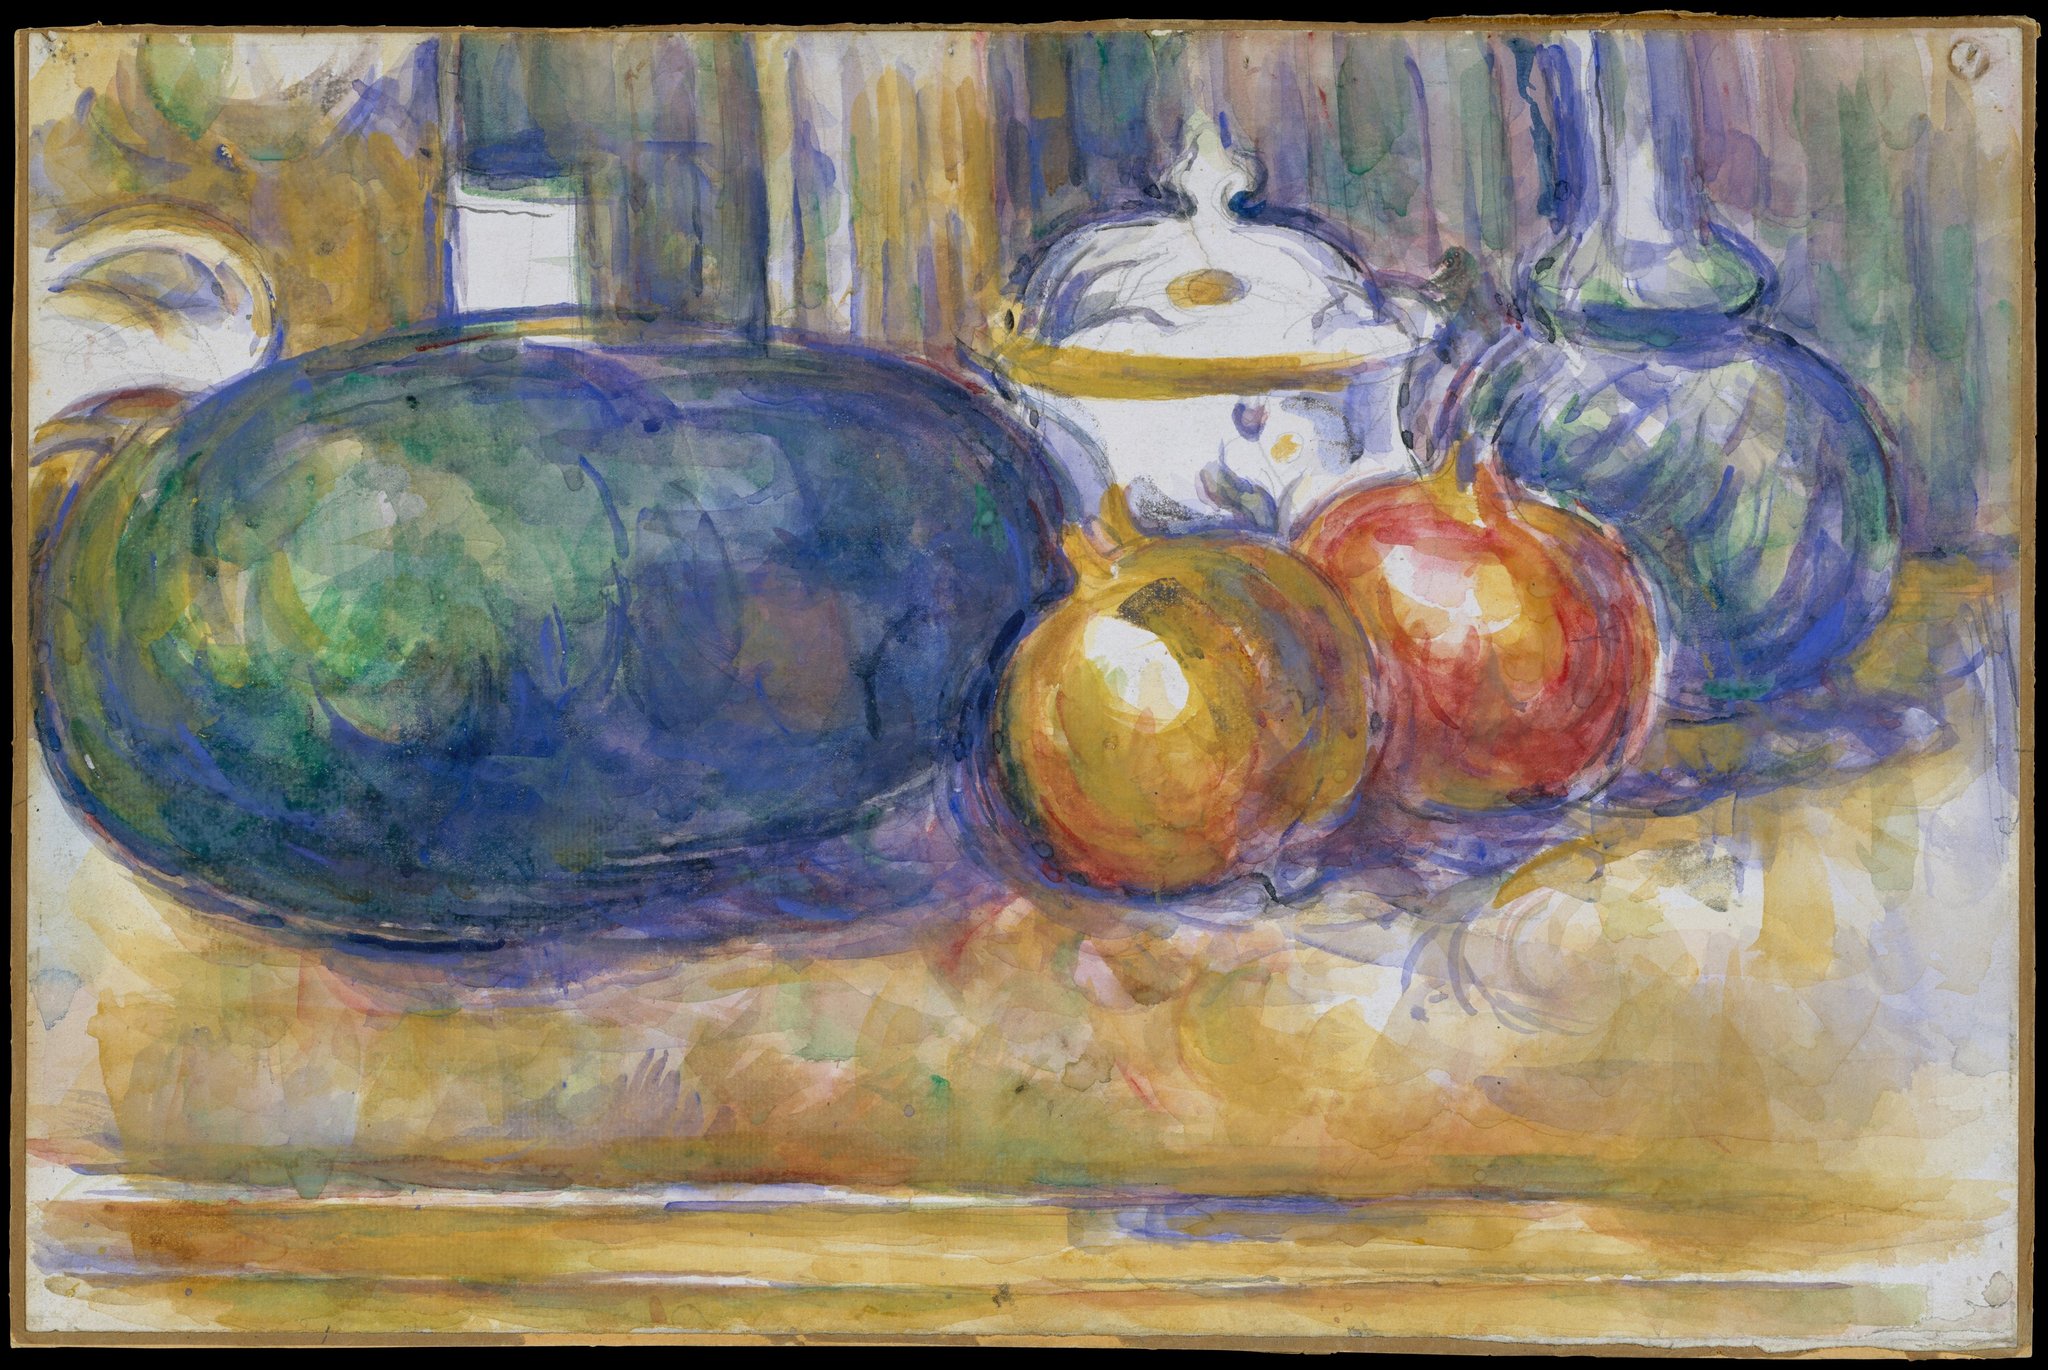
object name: drawing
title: Still-Life with a Watermelon and Pomegranates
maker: paul cézanne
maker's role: artist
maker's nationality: french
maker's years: 1839-1906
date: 1900-1906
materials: graphite, paper, watercolor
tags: pomegranates,still life